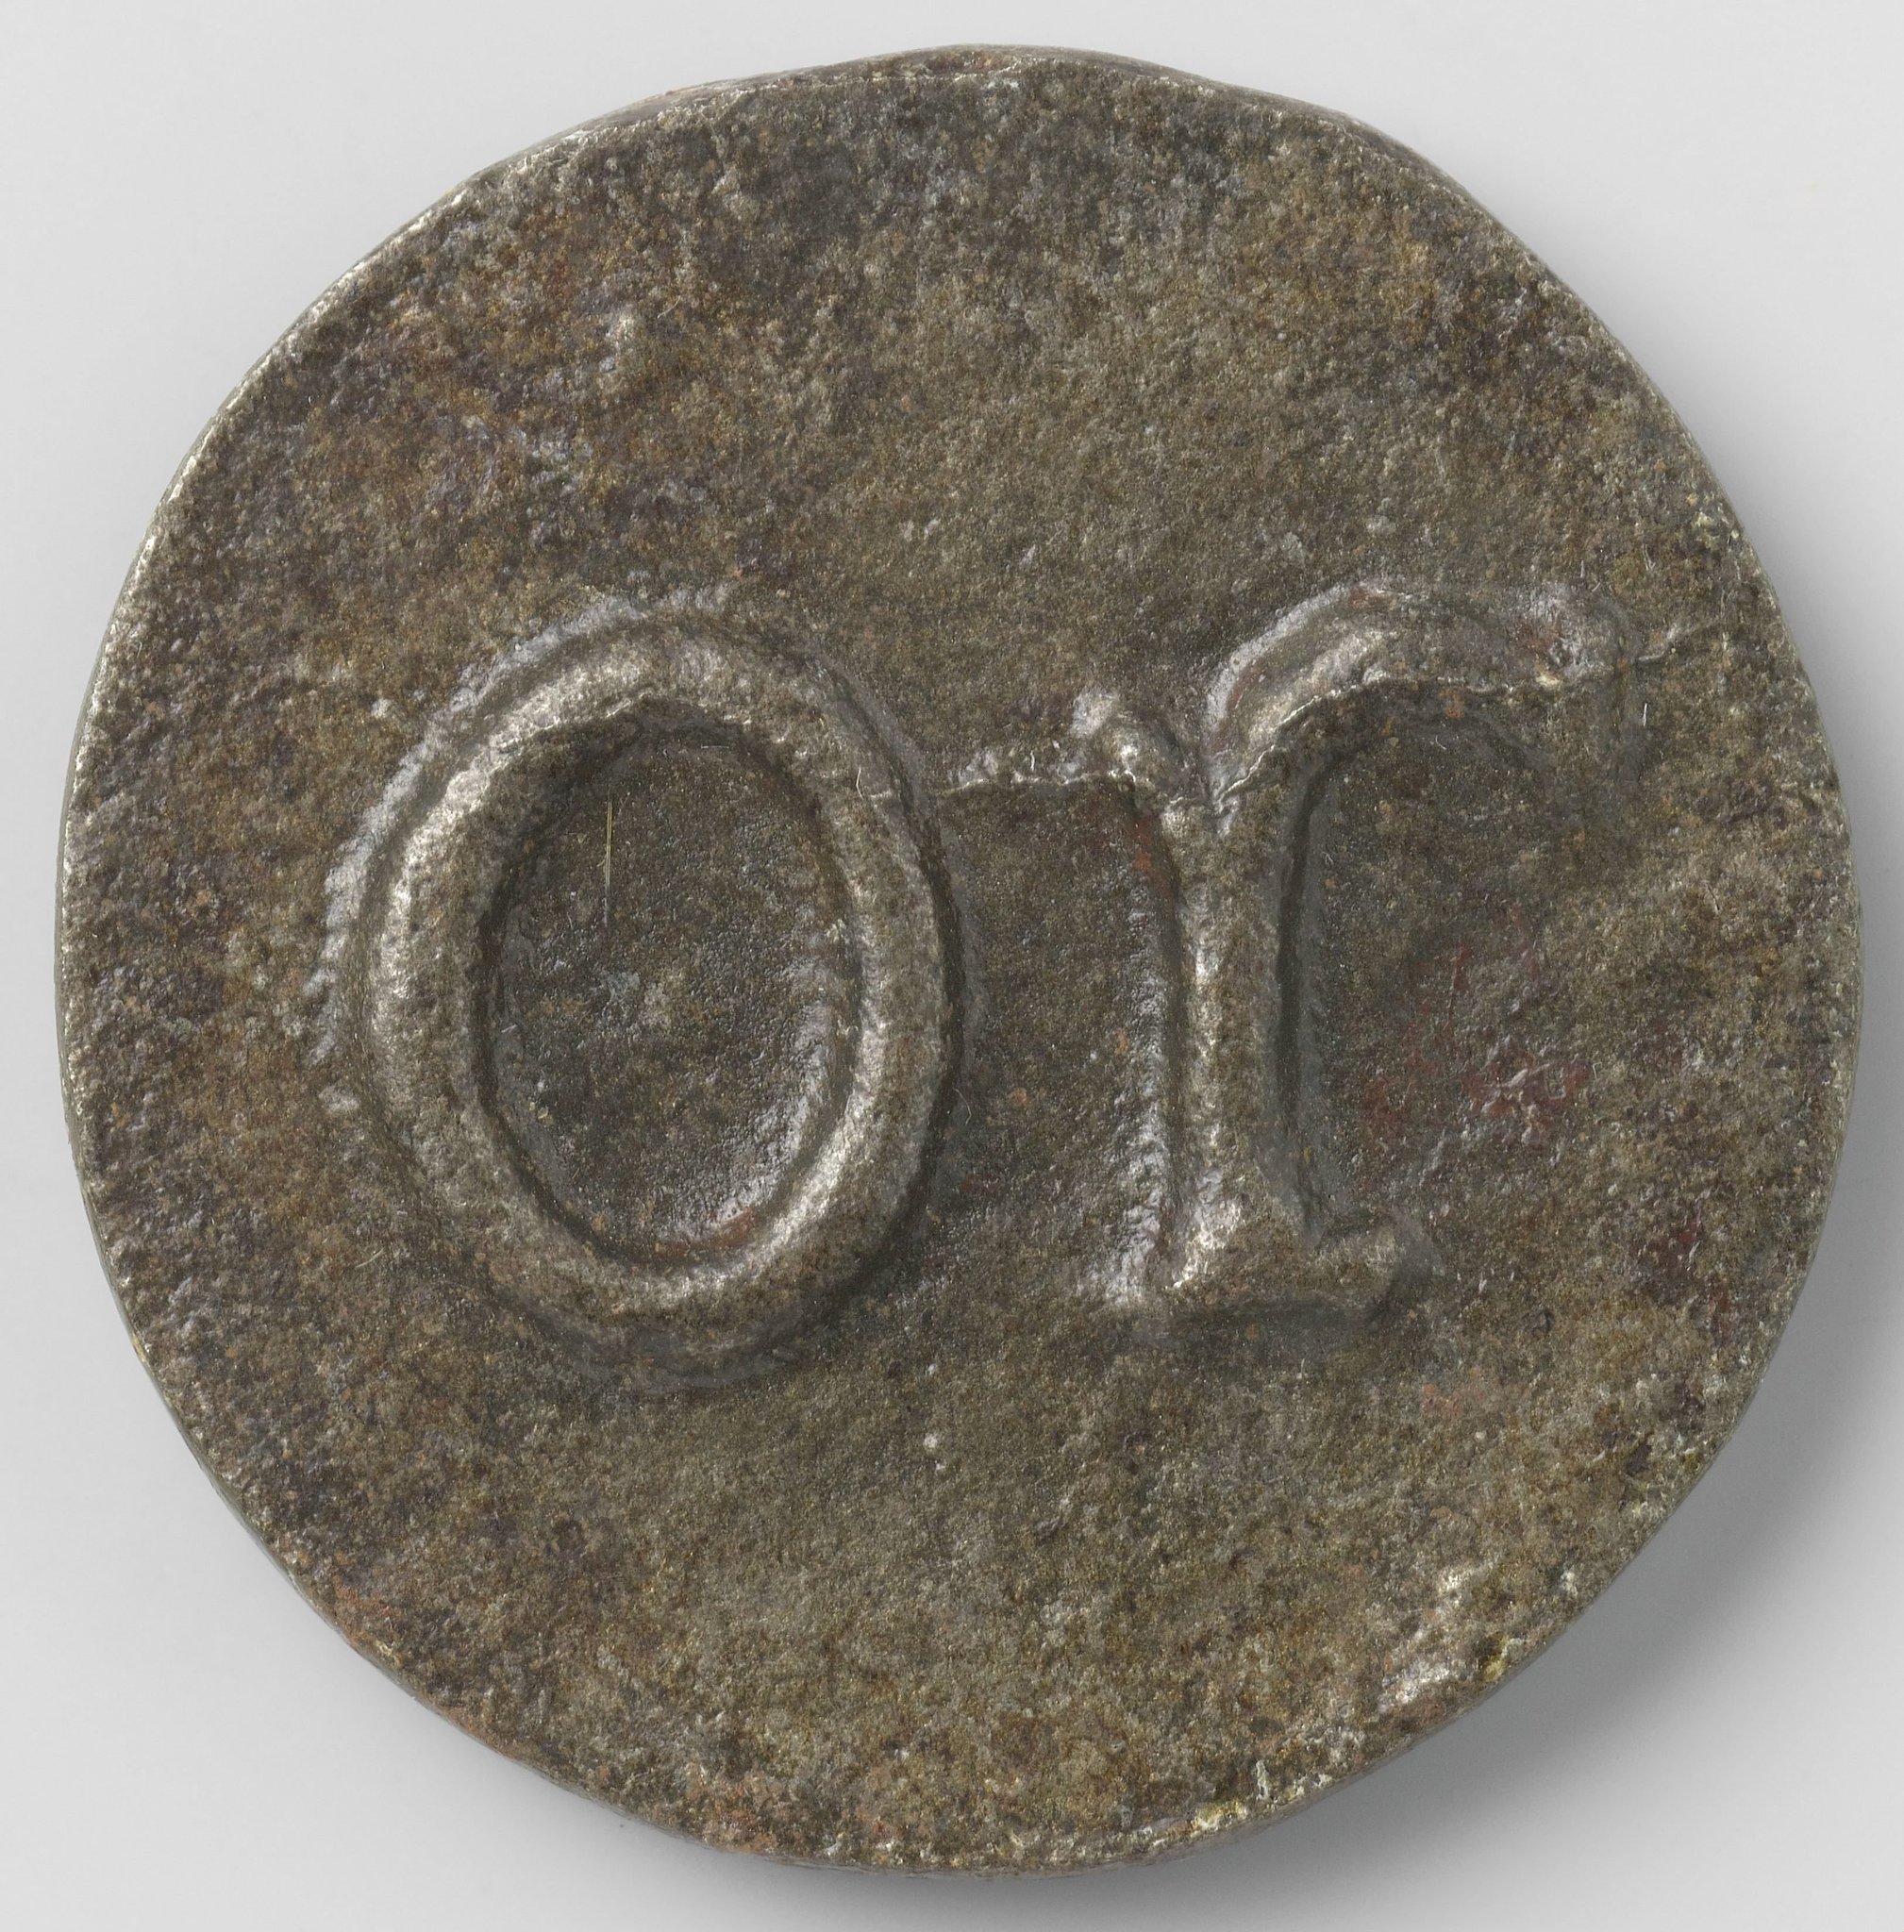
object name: monetary token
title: Strafgevangenis Ommerschans, huismunt geslagen op last van de Maatschappij van Weldadigheid ter waarde van tien cent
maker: Anonymous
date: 1818-1859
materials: iron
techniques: casting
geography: netherlands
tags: maatschappij van weldadigheid, ommerschans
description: Voorzijde: letters O en S. Keerzijde: cijfer 10